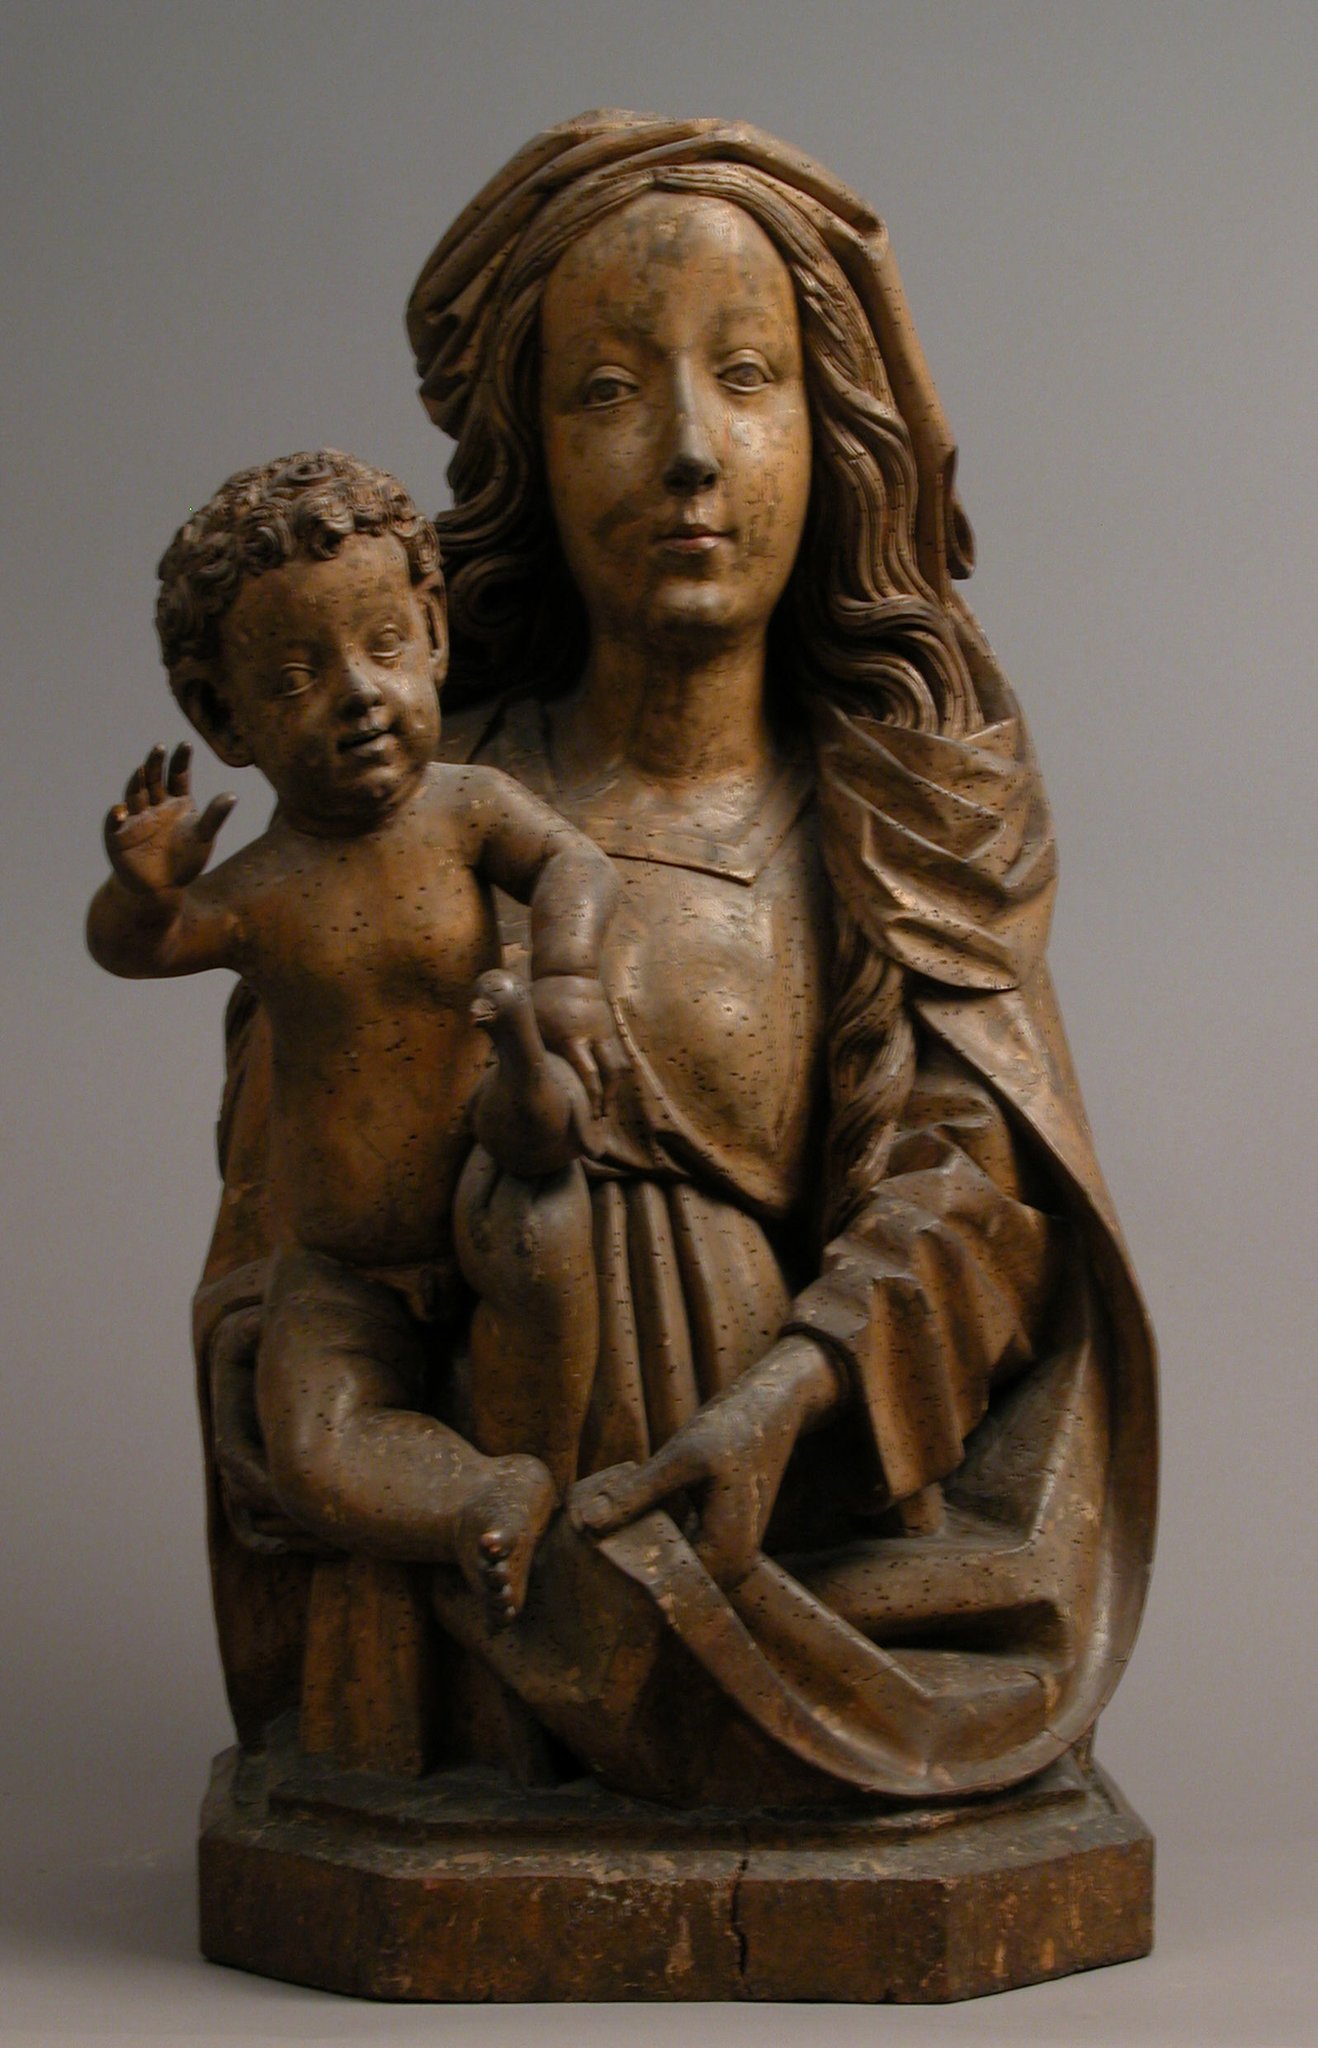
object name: statuette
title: Madonna and Child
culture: german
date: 1501-1600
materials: paint